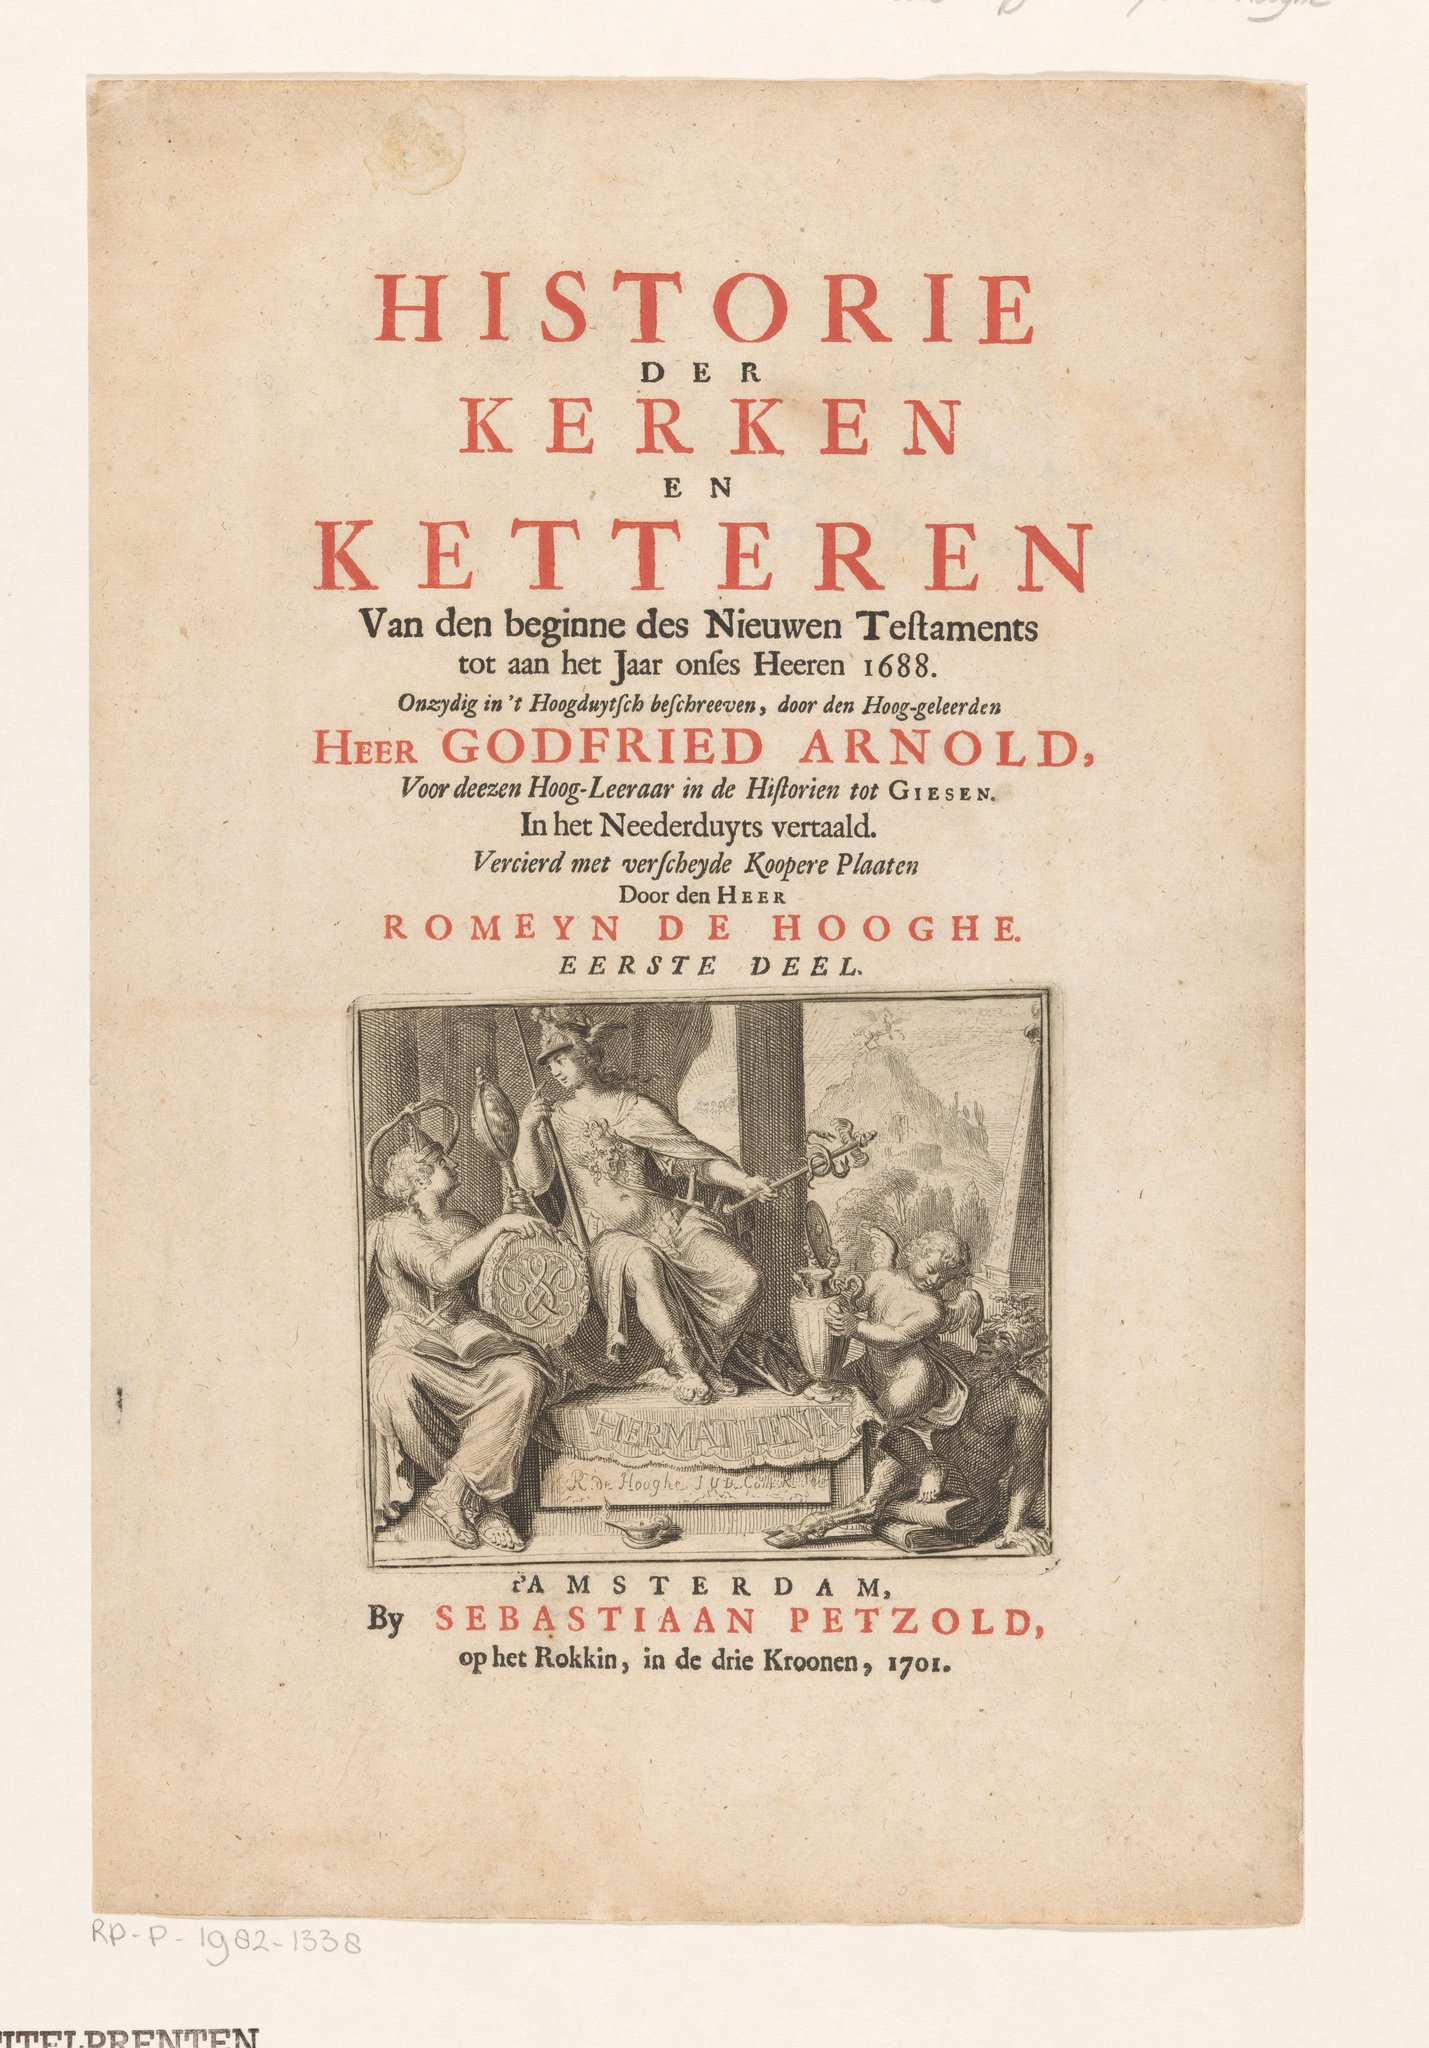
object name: titelblad, titelpagina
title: Hermathena en muze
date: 1701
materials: paper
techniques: etching, letterpress printing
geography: amsterdam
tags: hermathena (also if not in the form of a herm), single muses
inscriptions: collector's mark: Lugt 2760, collector's mark: Lugt 2228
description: Hermathena, een allegorische figuur met attributen van Minerva en Mercurius, zittend op een voetstuk. Zij kijkt naar een muze met de slang Ourobouros, een spiegel en een boek als personificatie van de kerk. Rechts zitten een sater en een putto met vaas.